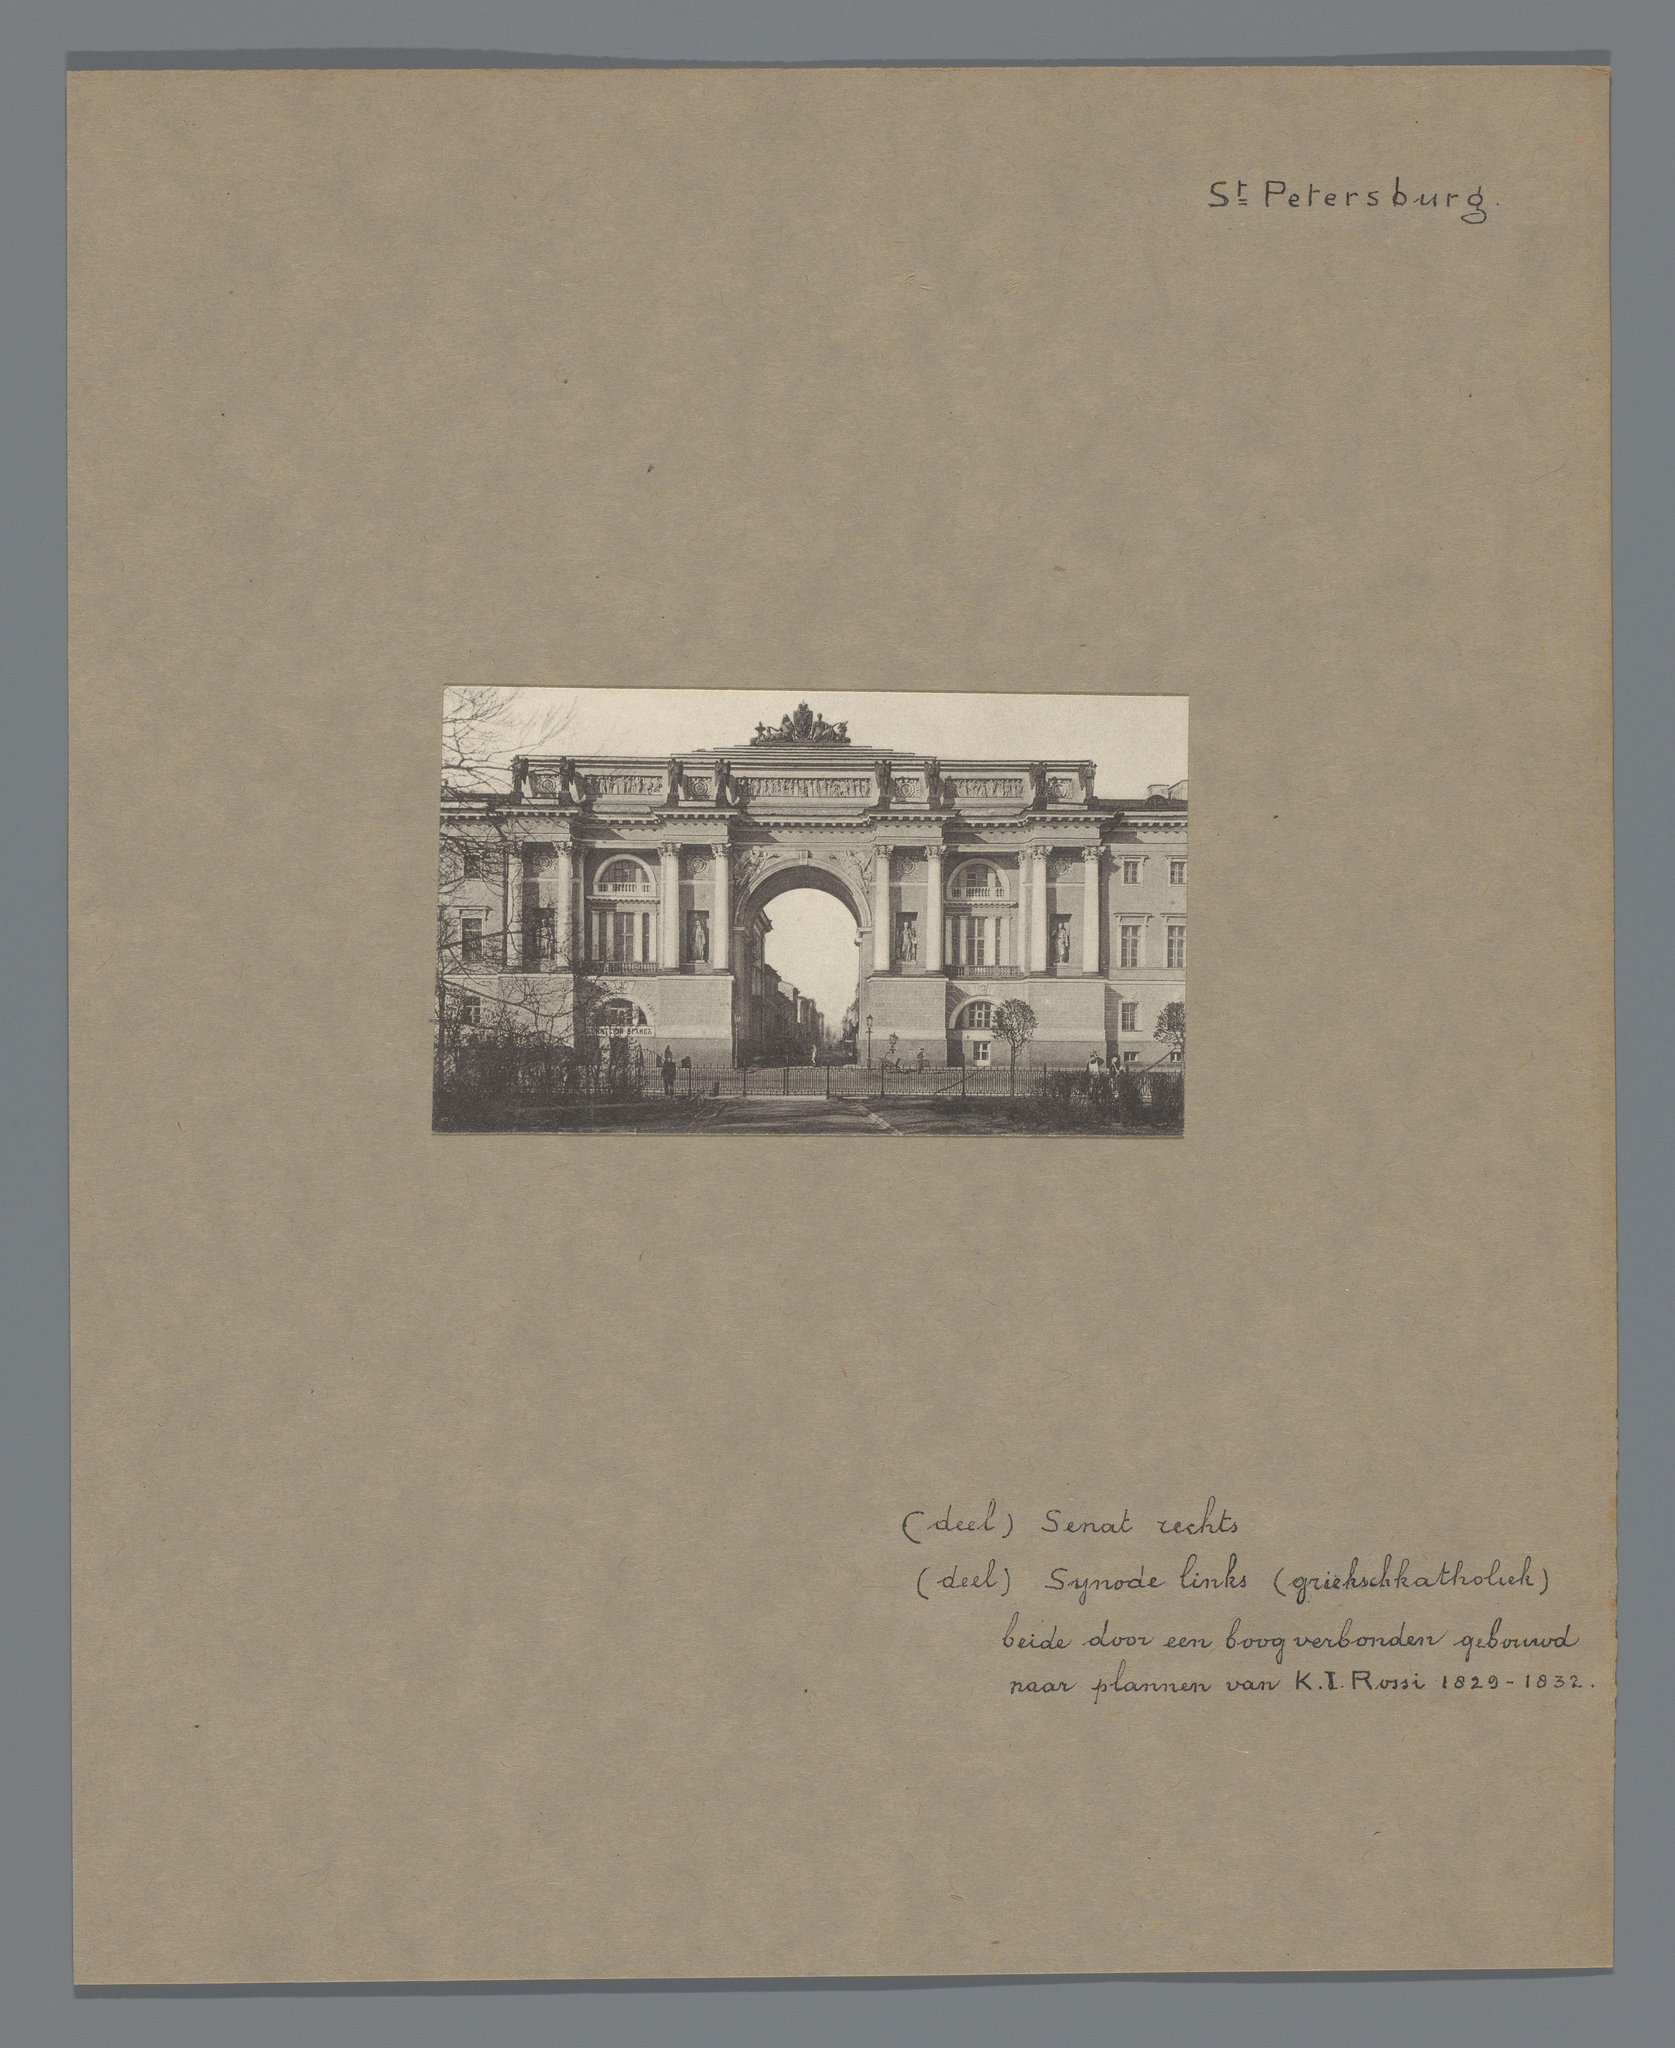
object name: photograph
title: St. Petersburg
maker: Anonymous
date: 1860-1925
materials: photographic support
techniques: photograph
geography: russia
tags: sint-petersburg